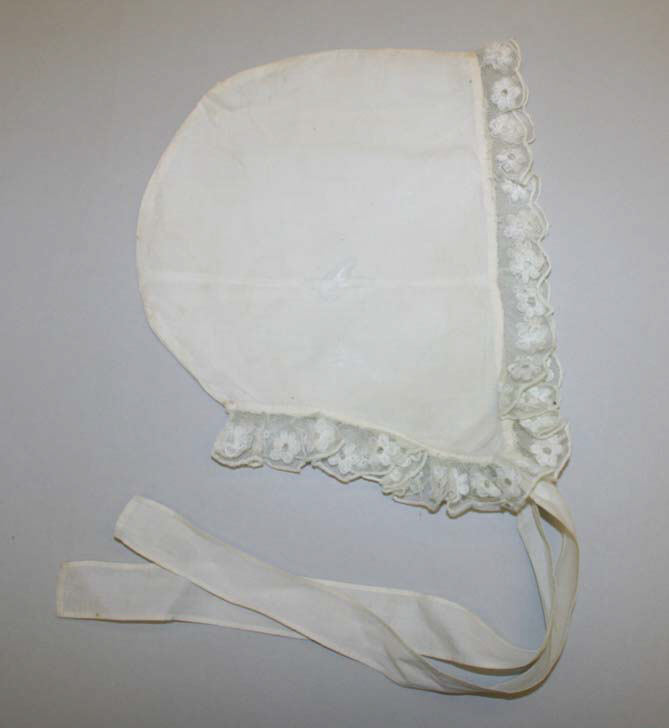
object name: cap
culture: american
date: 1767-1800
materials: linen